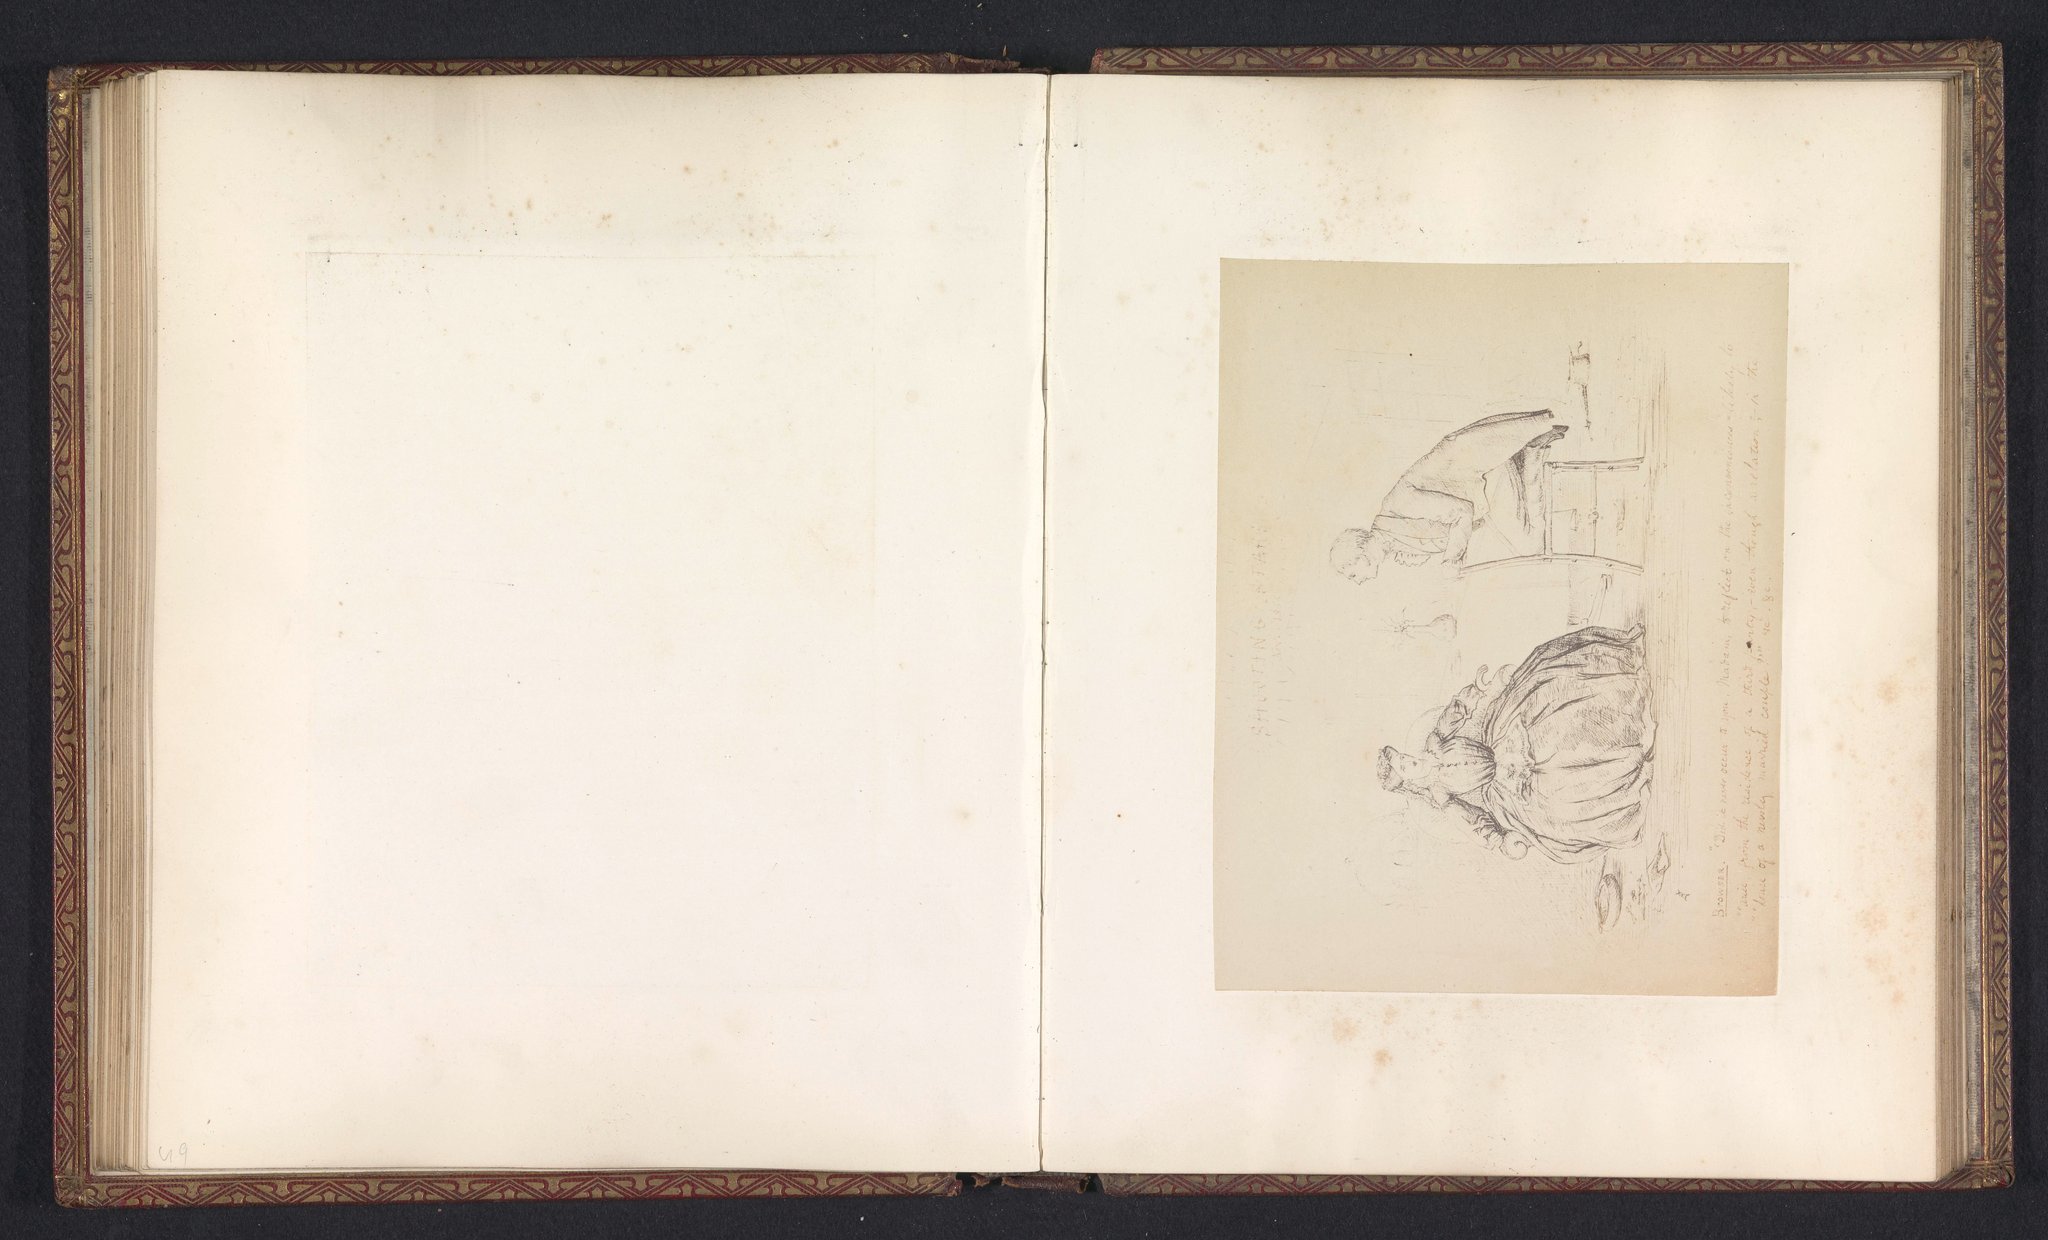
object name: page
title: Fotoreproductie van een tekening, voorstellende een vrouw en een man op een stoel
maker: Anonymous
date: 1855-1866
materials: photographic support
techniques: albumen print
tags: adult woman, caricatures (human types), adult man, student life